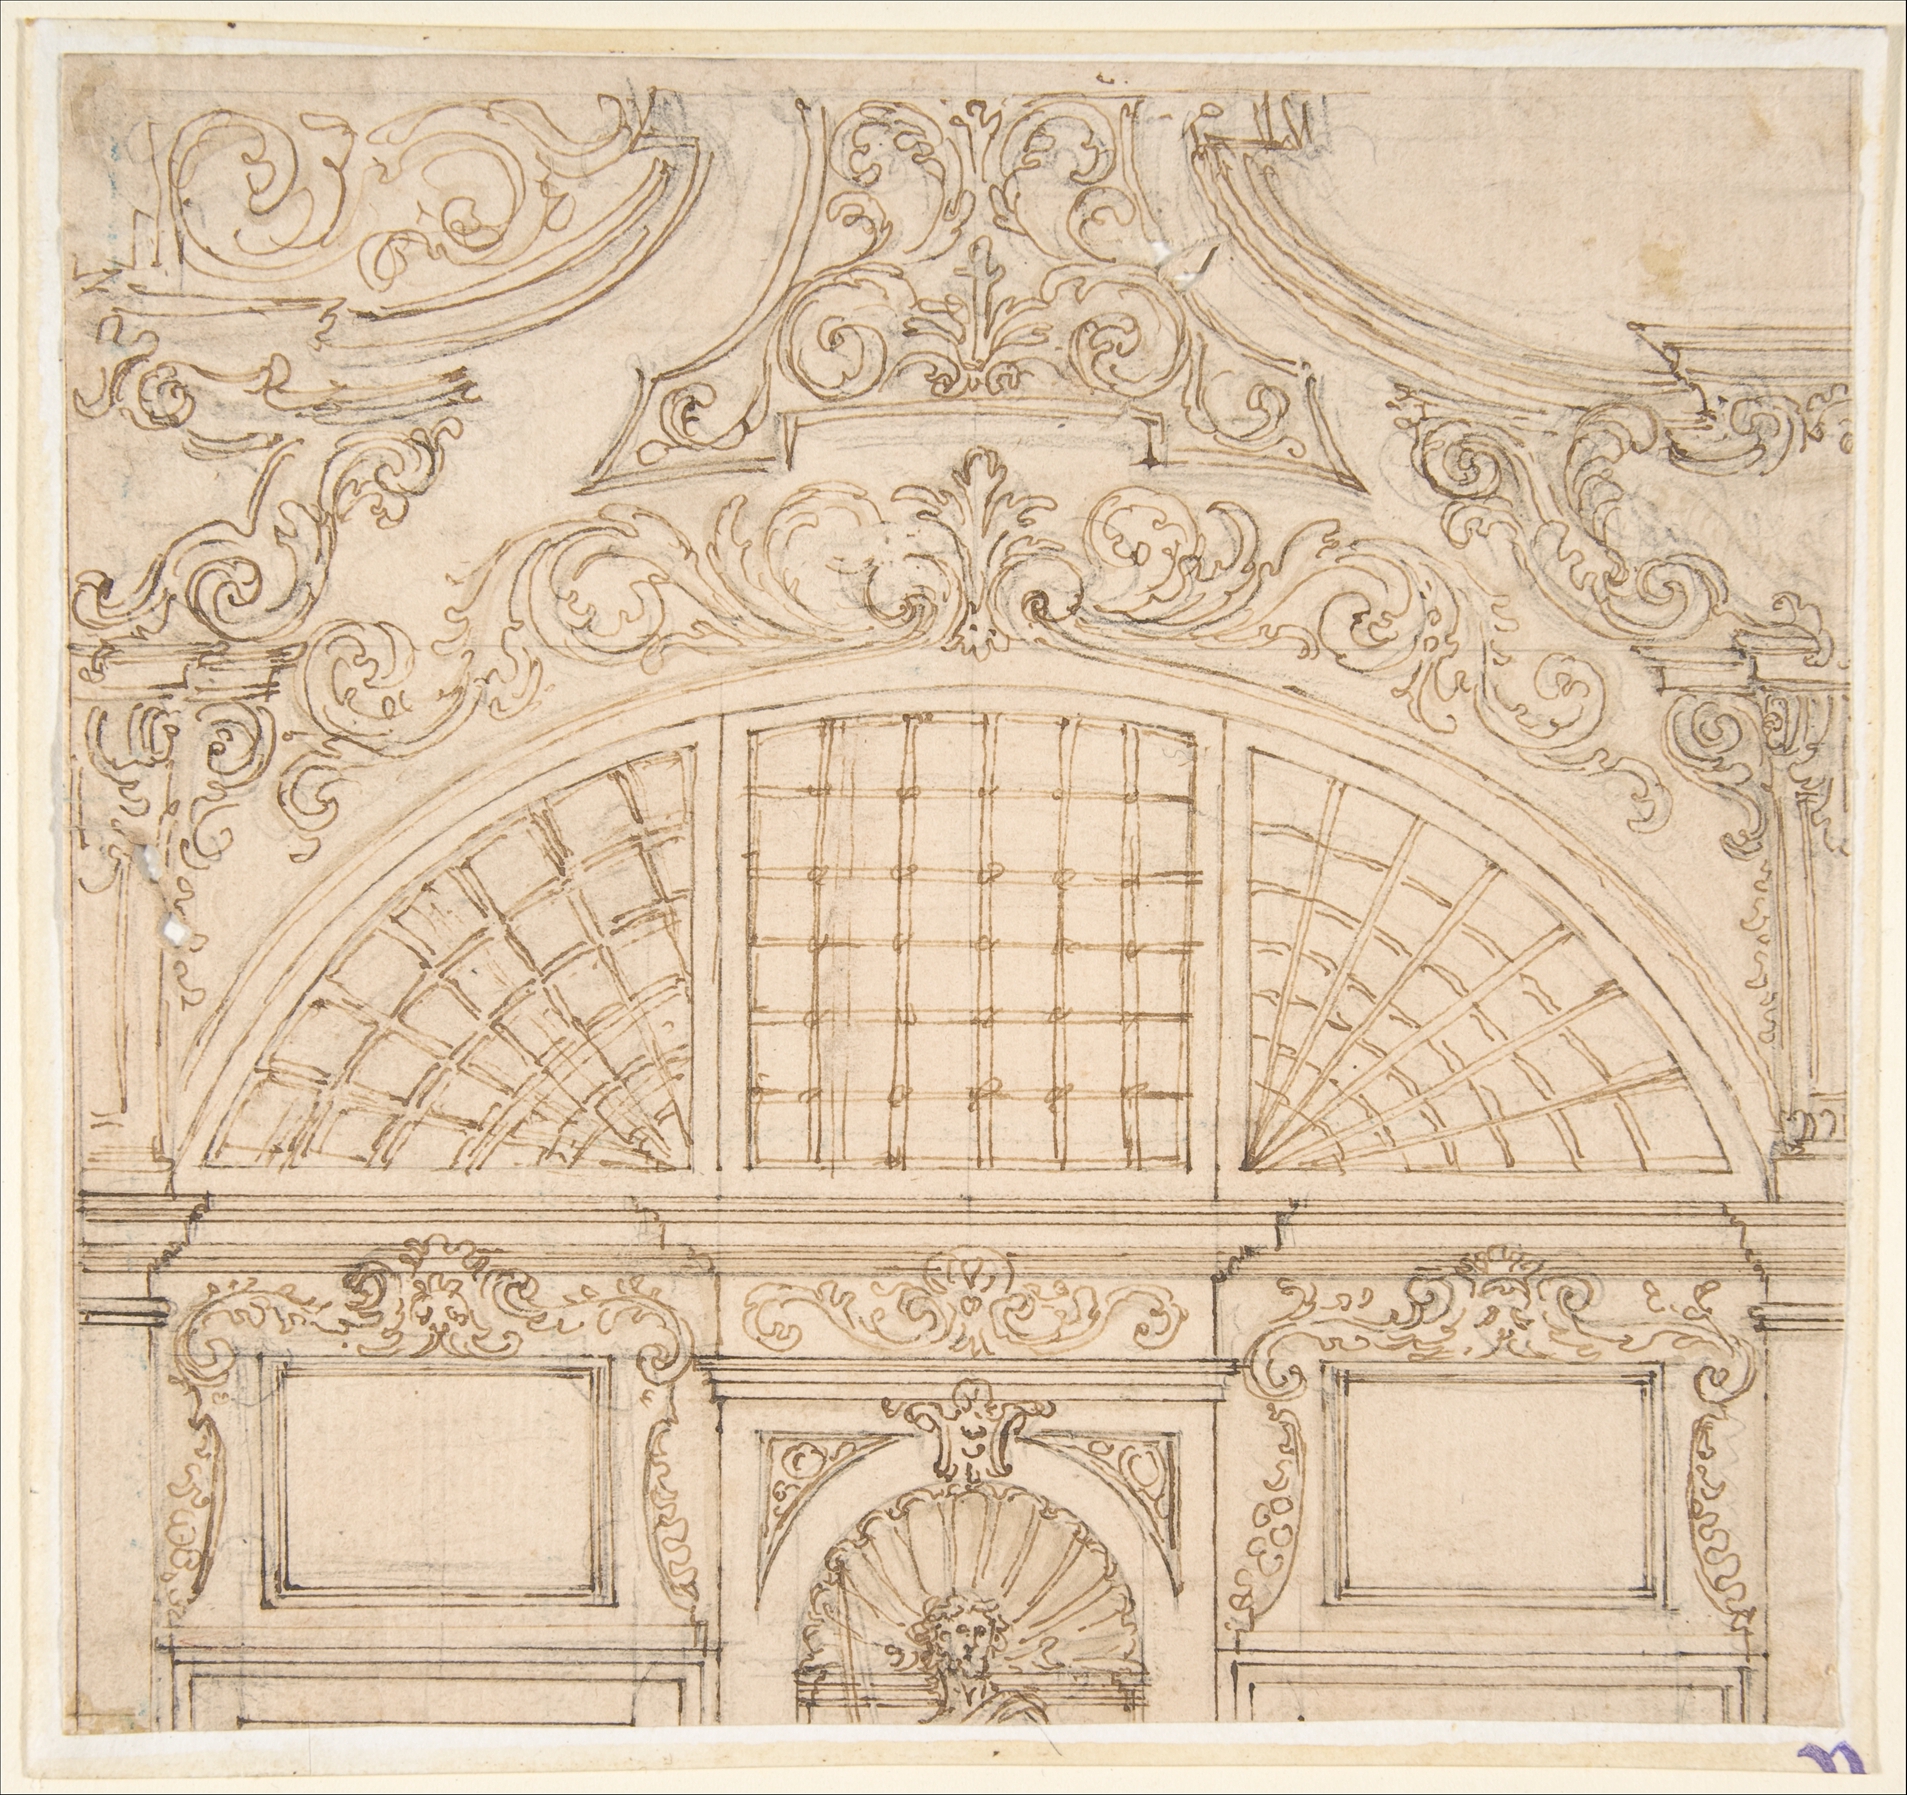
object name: drawing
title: Design for the Upper Half of a Wall Elevation with a Semicircular Window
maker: giovanni battista foggini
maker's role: artist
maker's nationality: italian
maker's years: 1652-1725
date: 1672-1725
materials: chalk, ink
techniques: brush, pen, wash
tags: architecture,windows